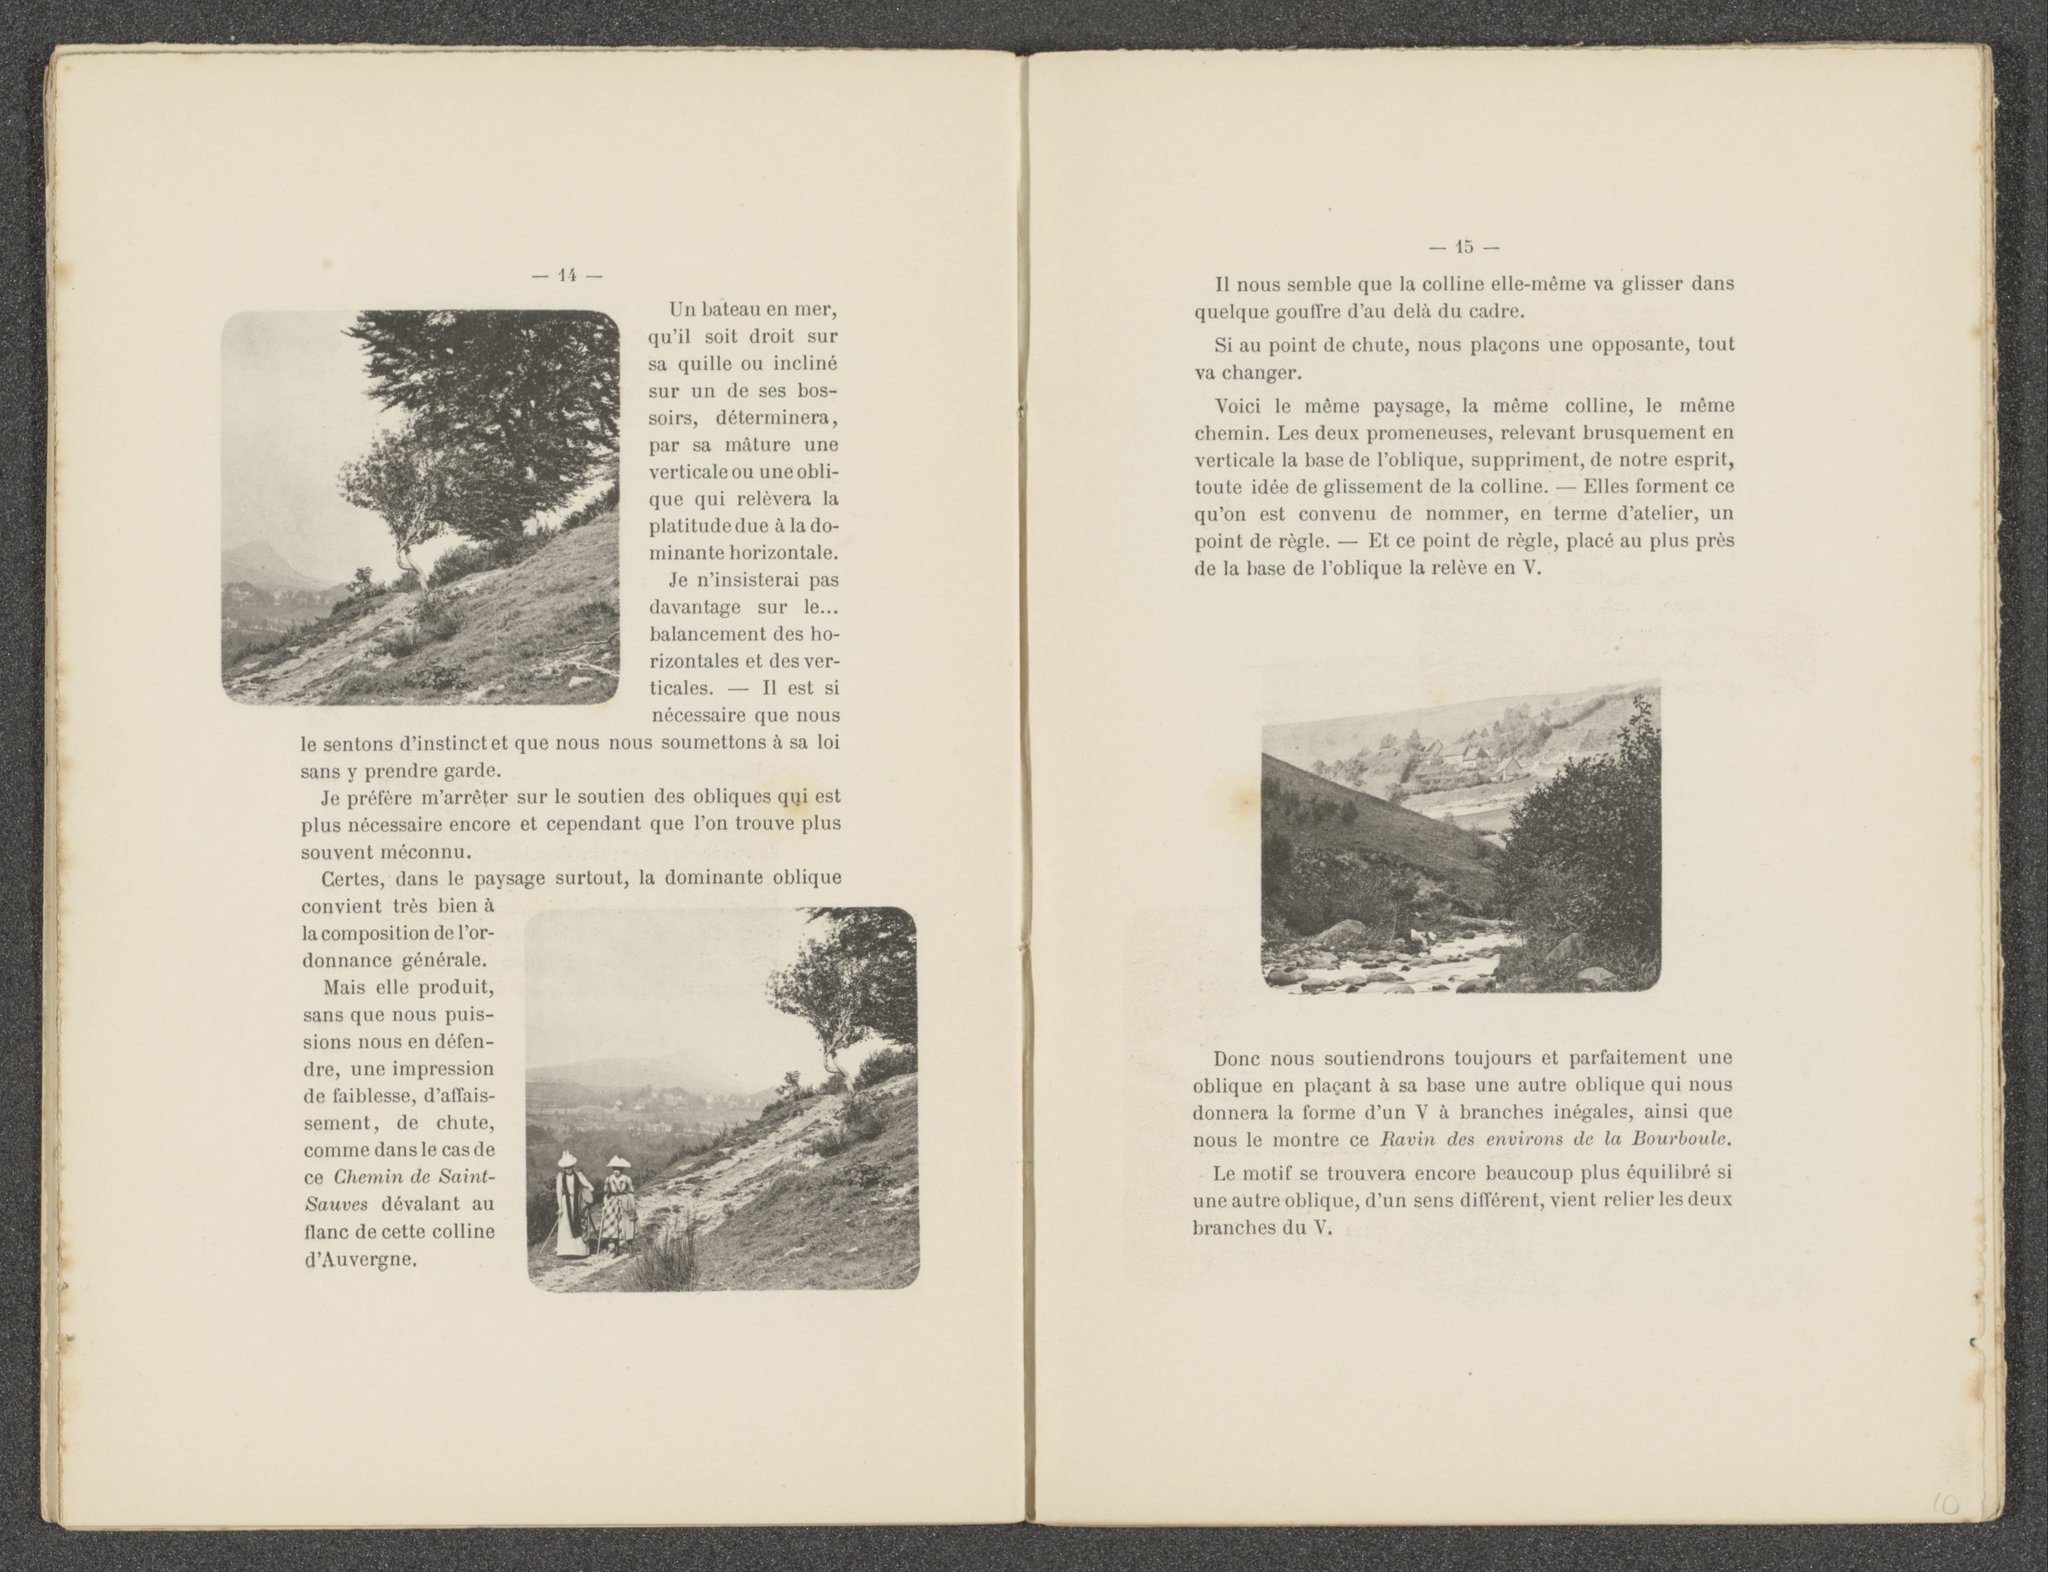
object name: photomechanical print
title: Twee gezichten op een bergpad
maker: Anonymous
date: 1886-1896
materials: paper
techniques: photograph, printing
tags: adult woman, road, path, mountains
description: Boven een gezicht op een bergpad, onder een bergpad met twee vrouwen.